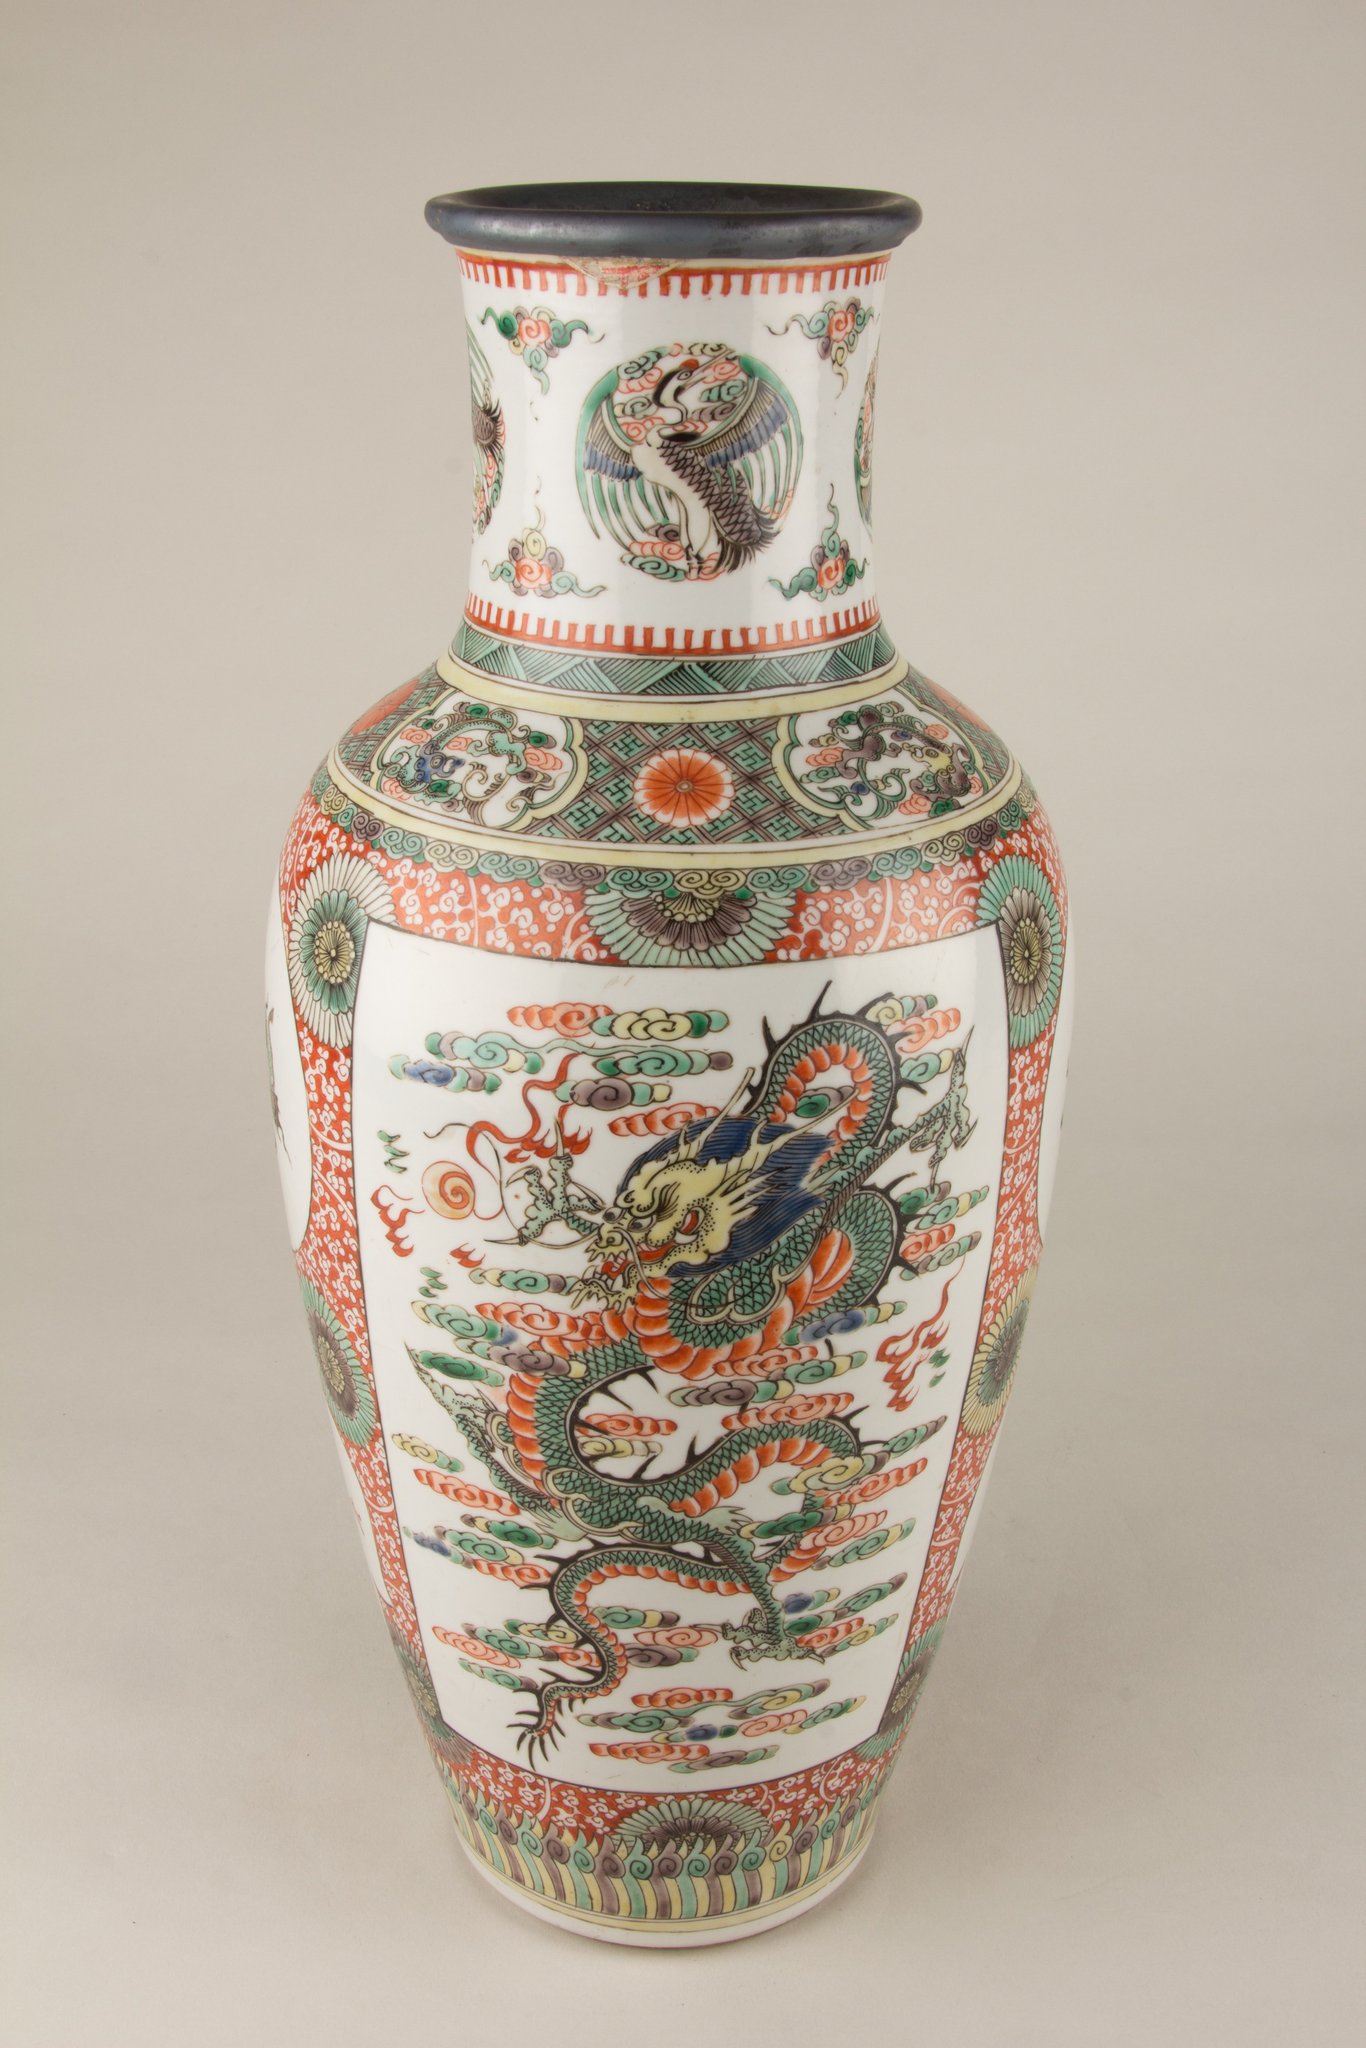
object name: vase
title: Vase with dragon, phoenixes, and butterflies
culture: chinese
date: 1701-1800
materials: enamel, porcelain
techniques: overglaze, painting, polychrome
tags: dragons